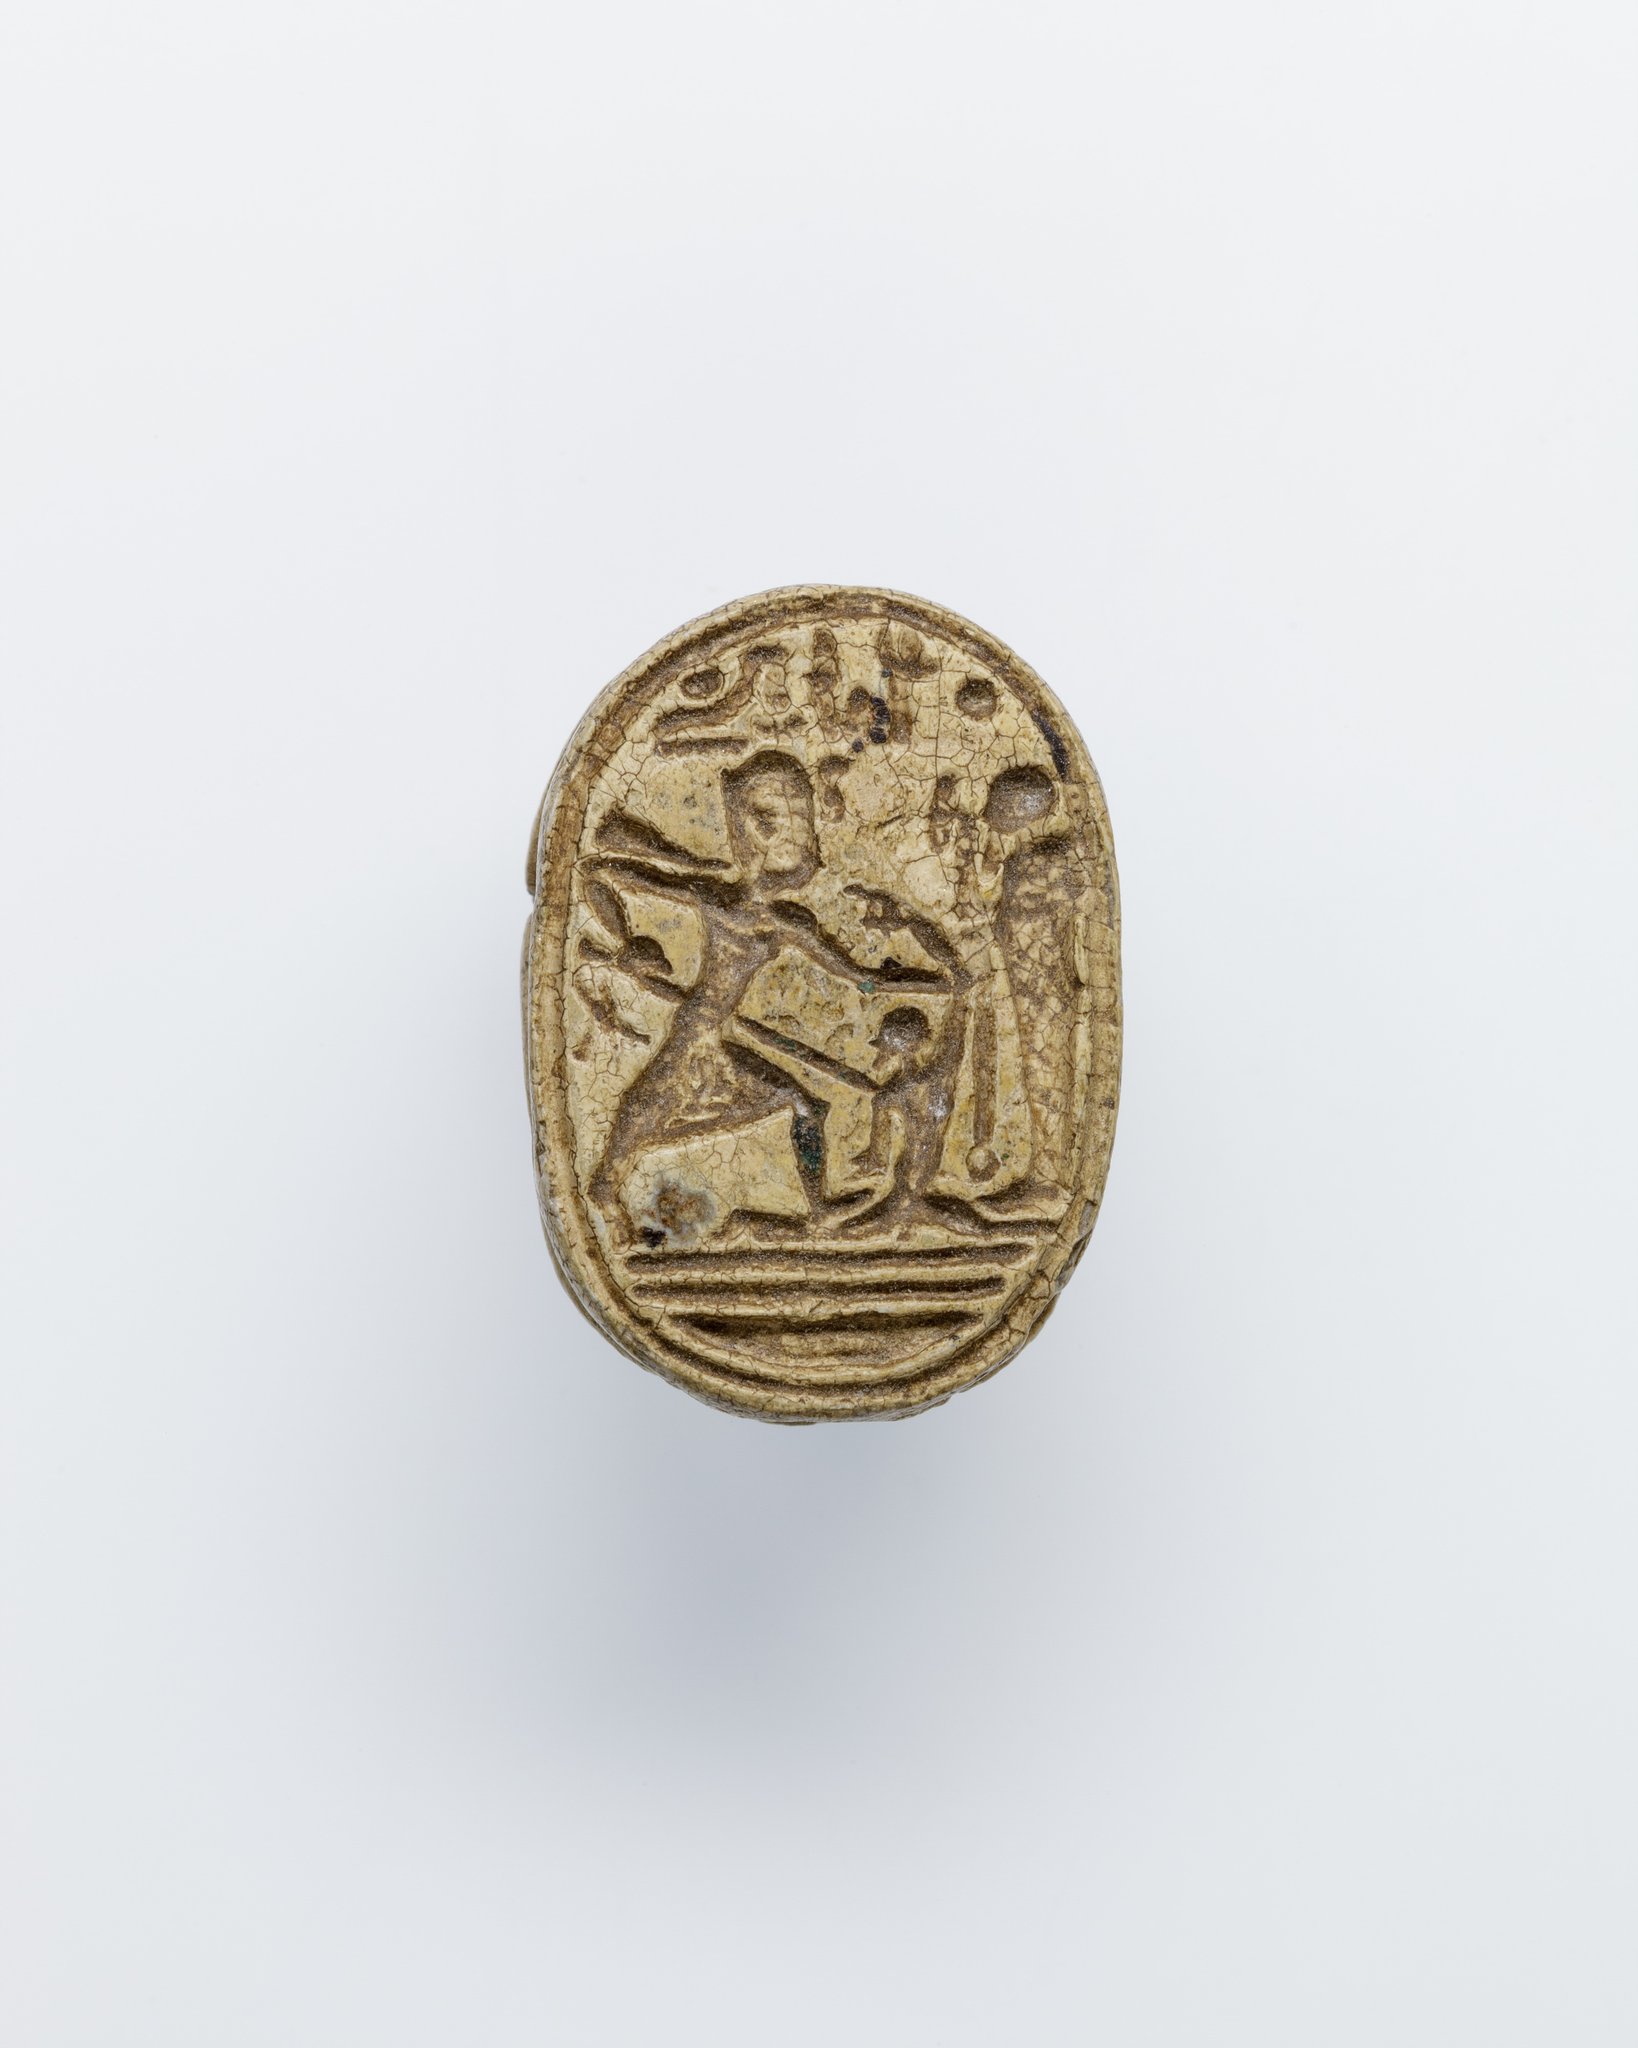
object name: scarab, ramesses ii, ptah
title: Scarab Depicting Ramesses II Smiting a Captive Before the God Ptah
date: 1279-1213 BCE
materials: stone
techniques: glazing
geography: egypt